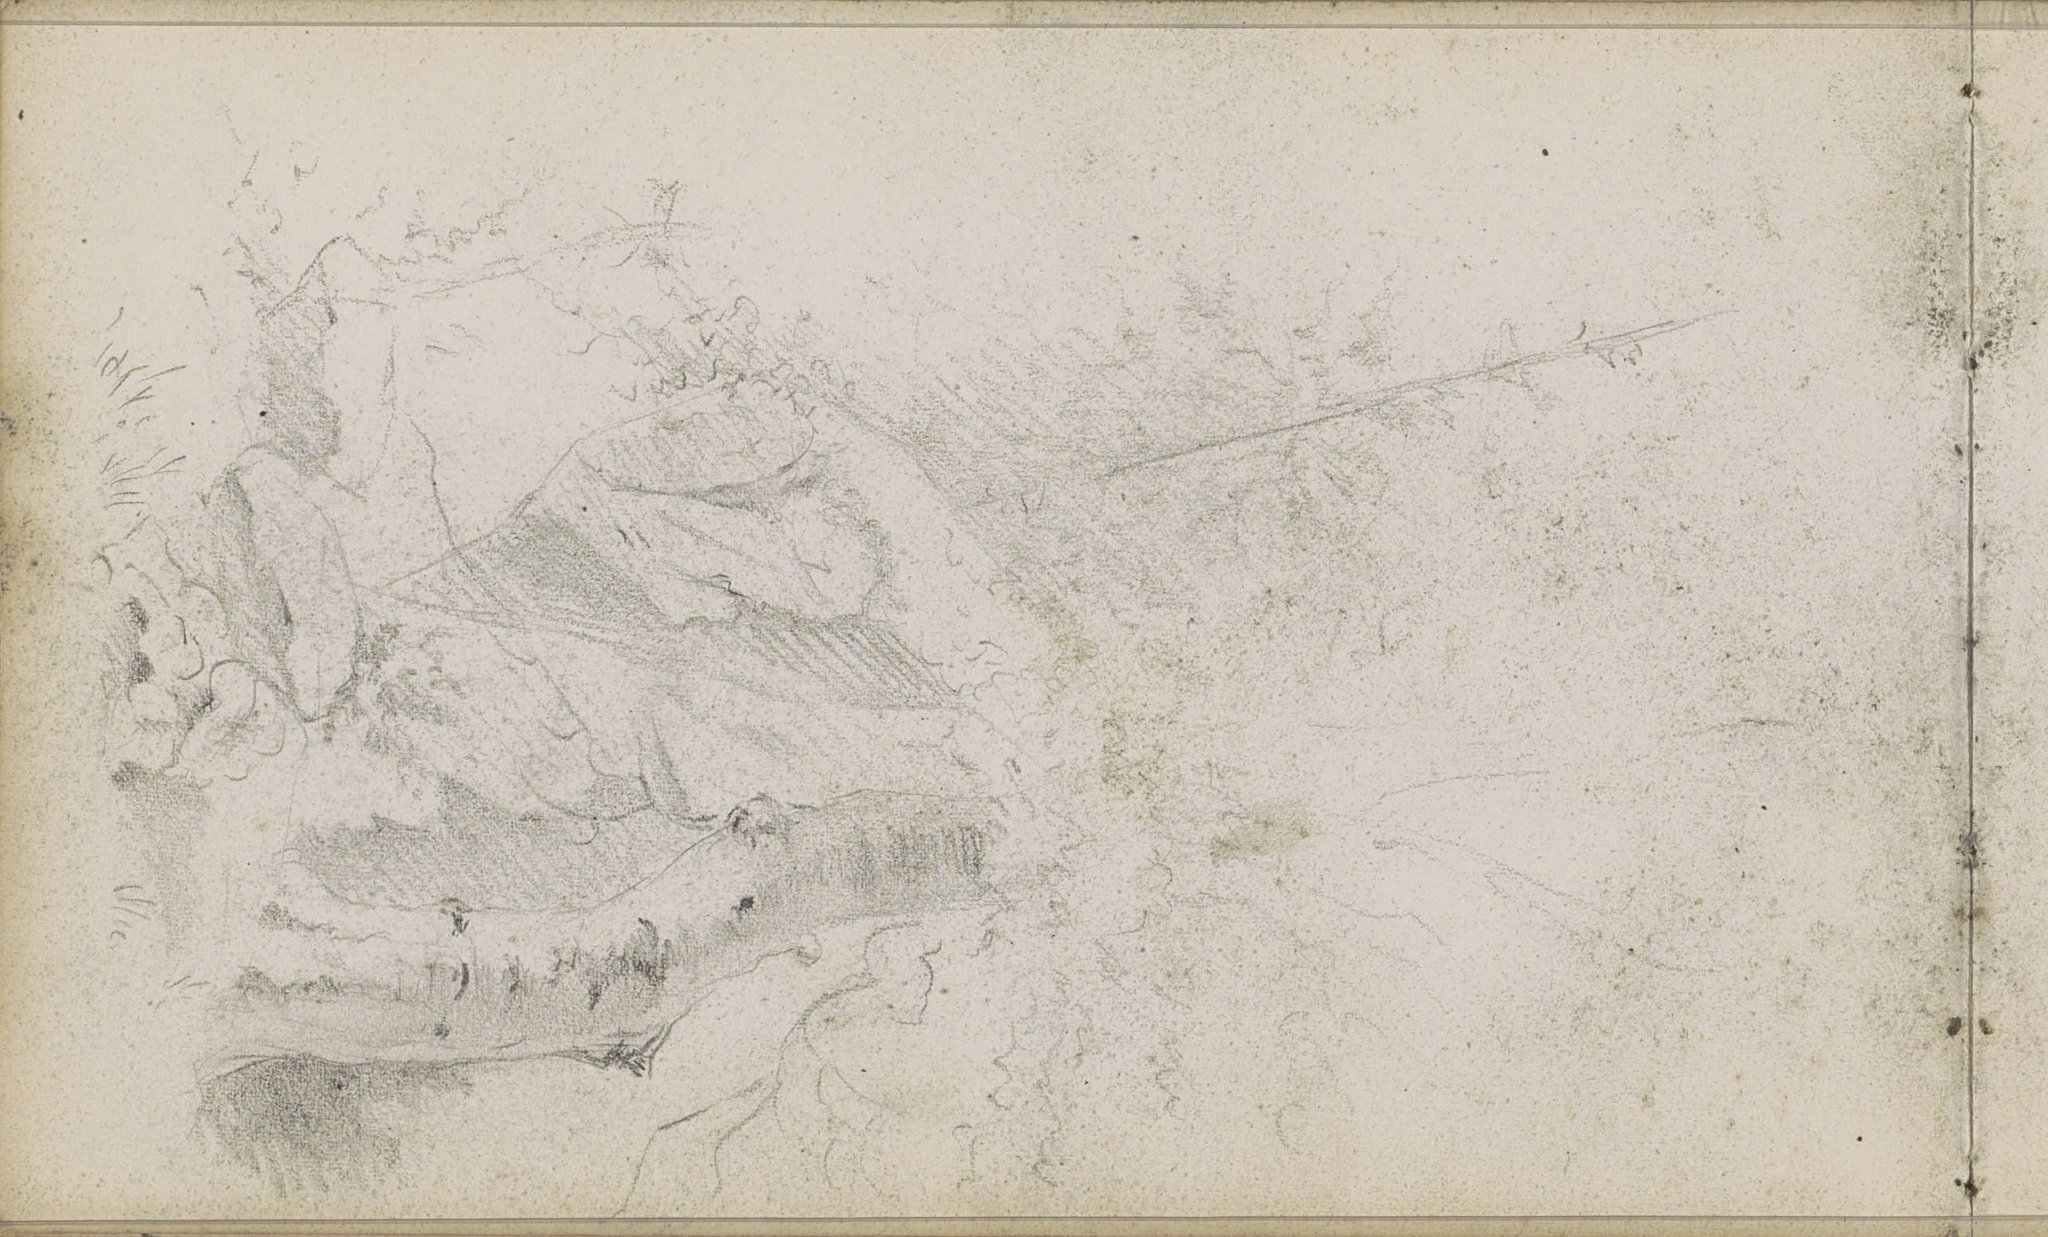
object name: sketchbook leaf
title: Bomen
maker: willem cornelis rip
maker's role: draughtsman, painter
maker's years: 1856-1922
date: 1874-1875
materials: paper, pencil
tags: trees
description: Blad 7 verso uit een schetsboek met 46 bladen.